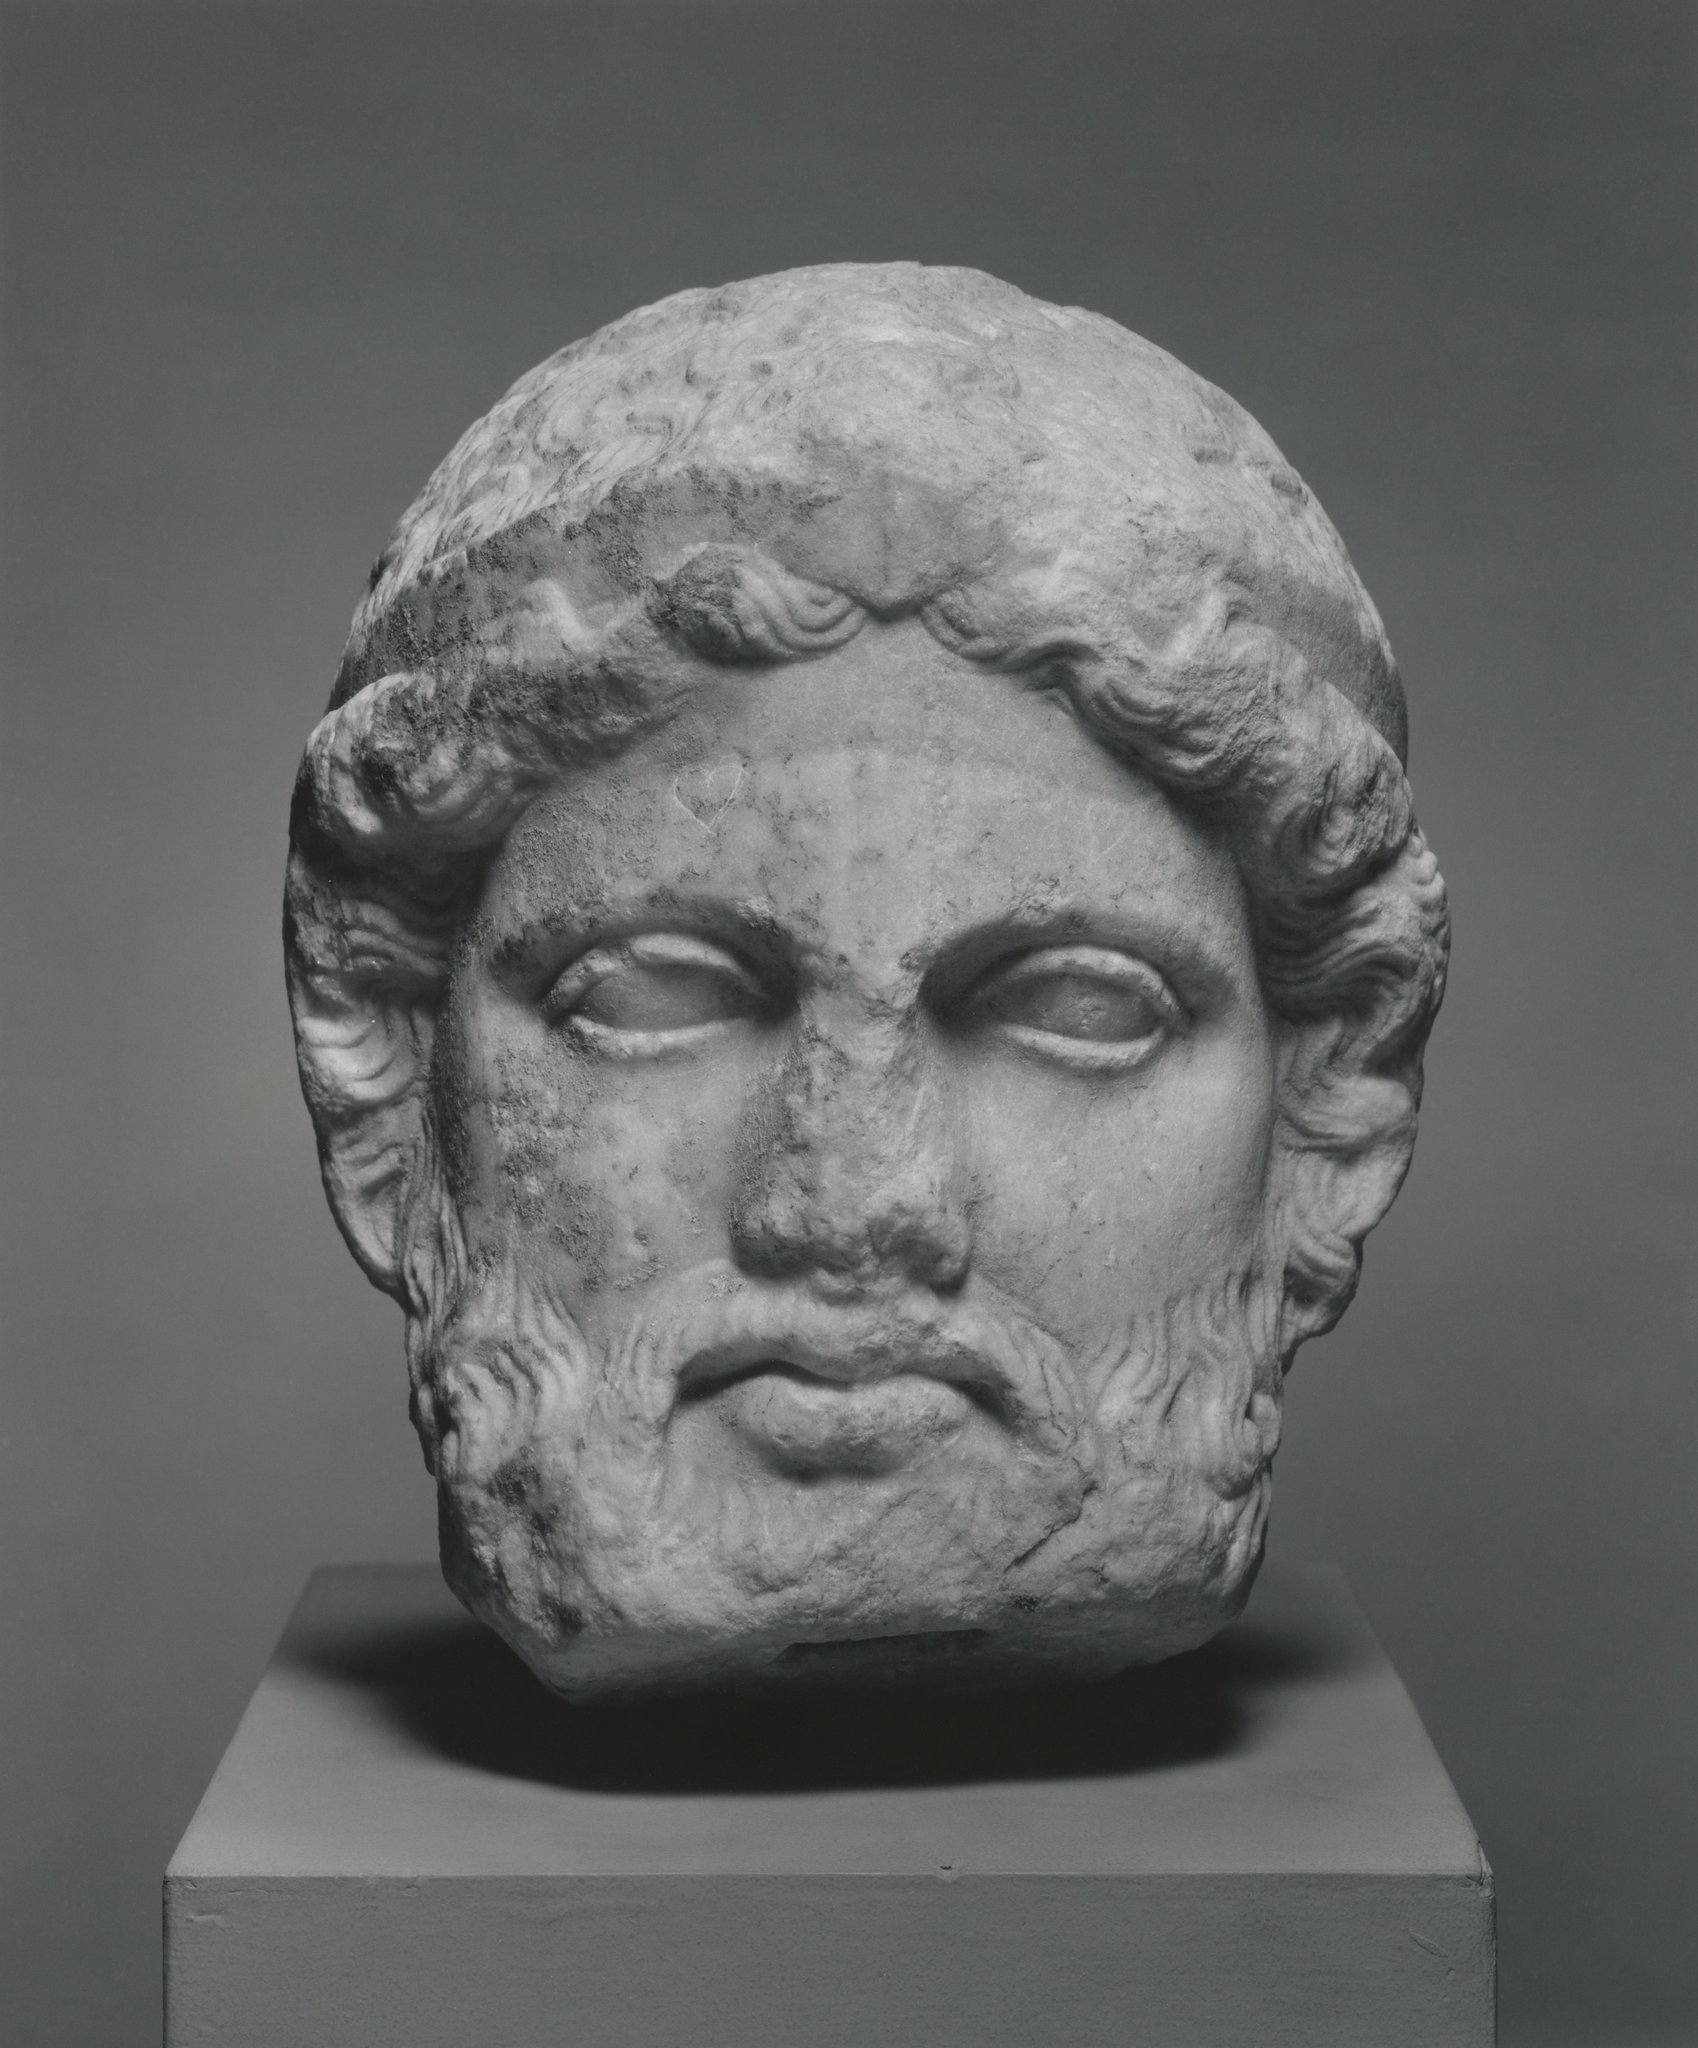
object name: head from a herm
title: Marble head from a herm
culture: greek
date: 434-401 BCE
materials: marble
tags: heads,hermes